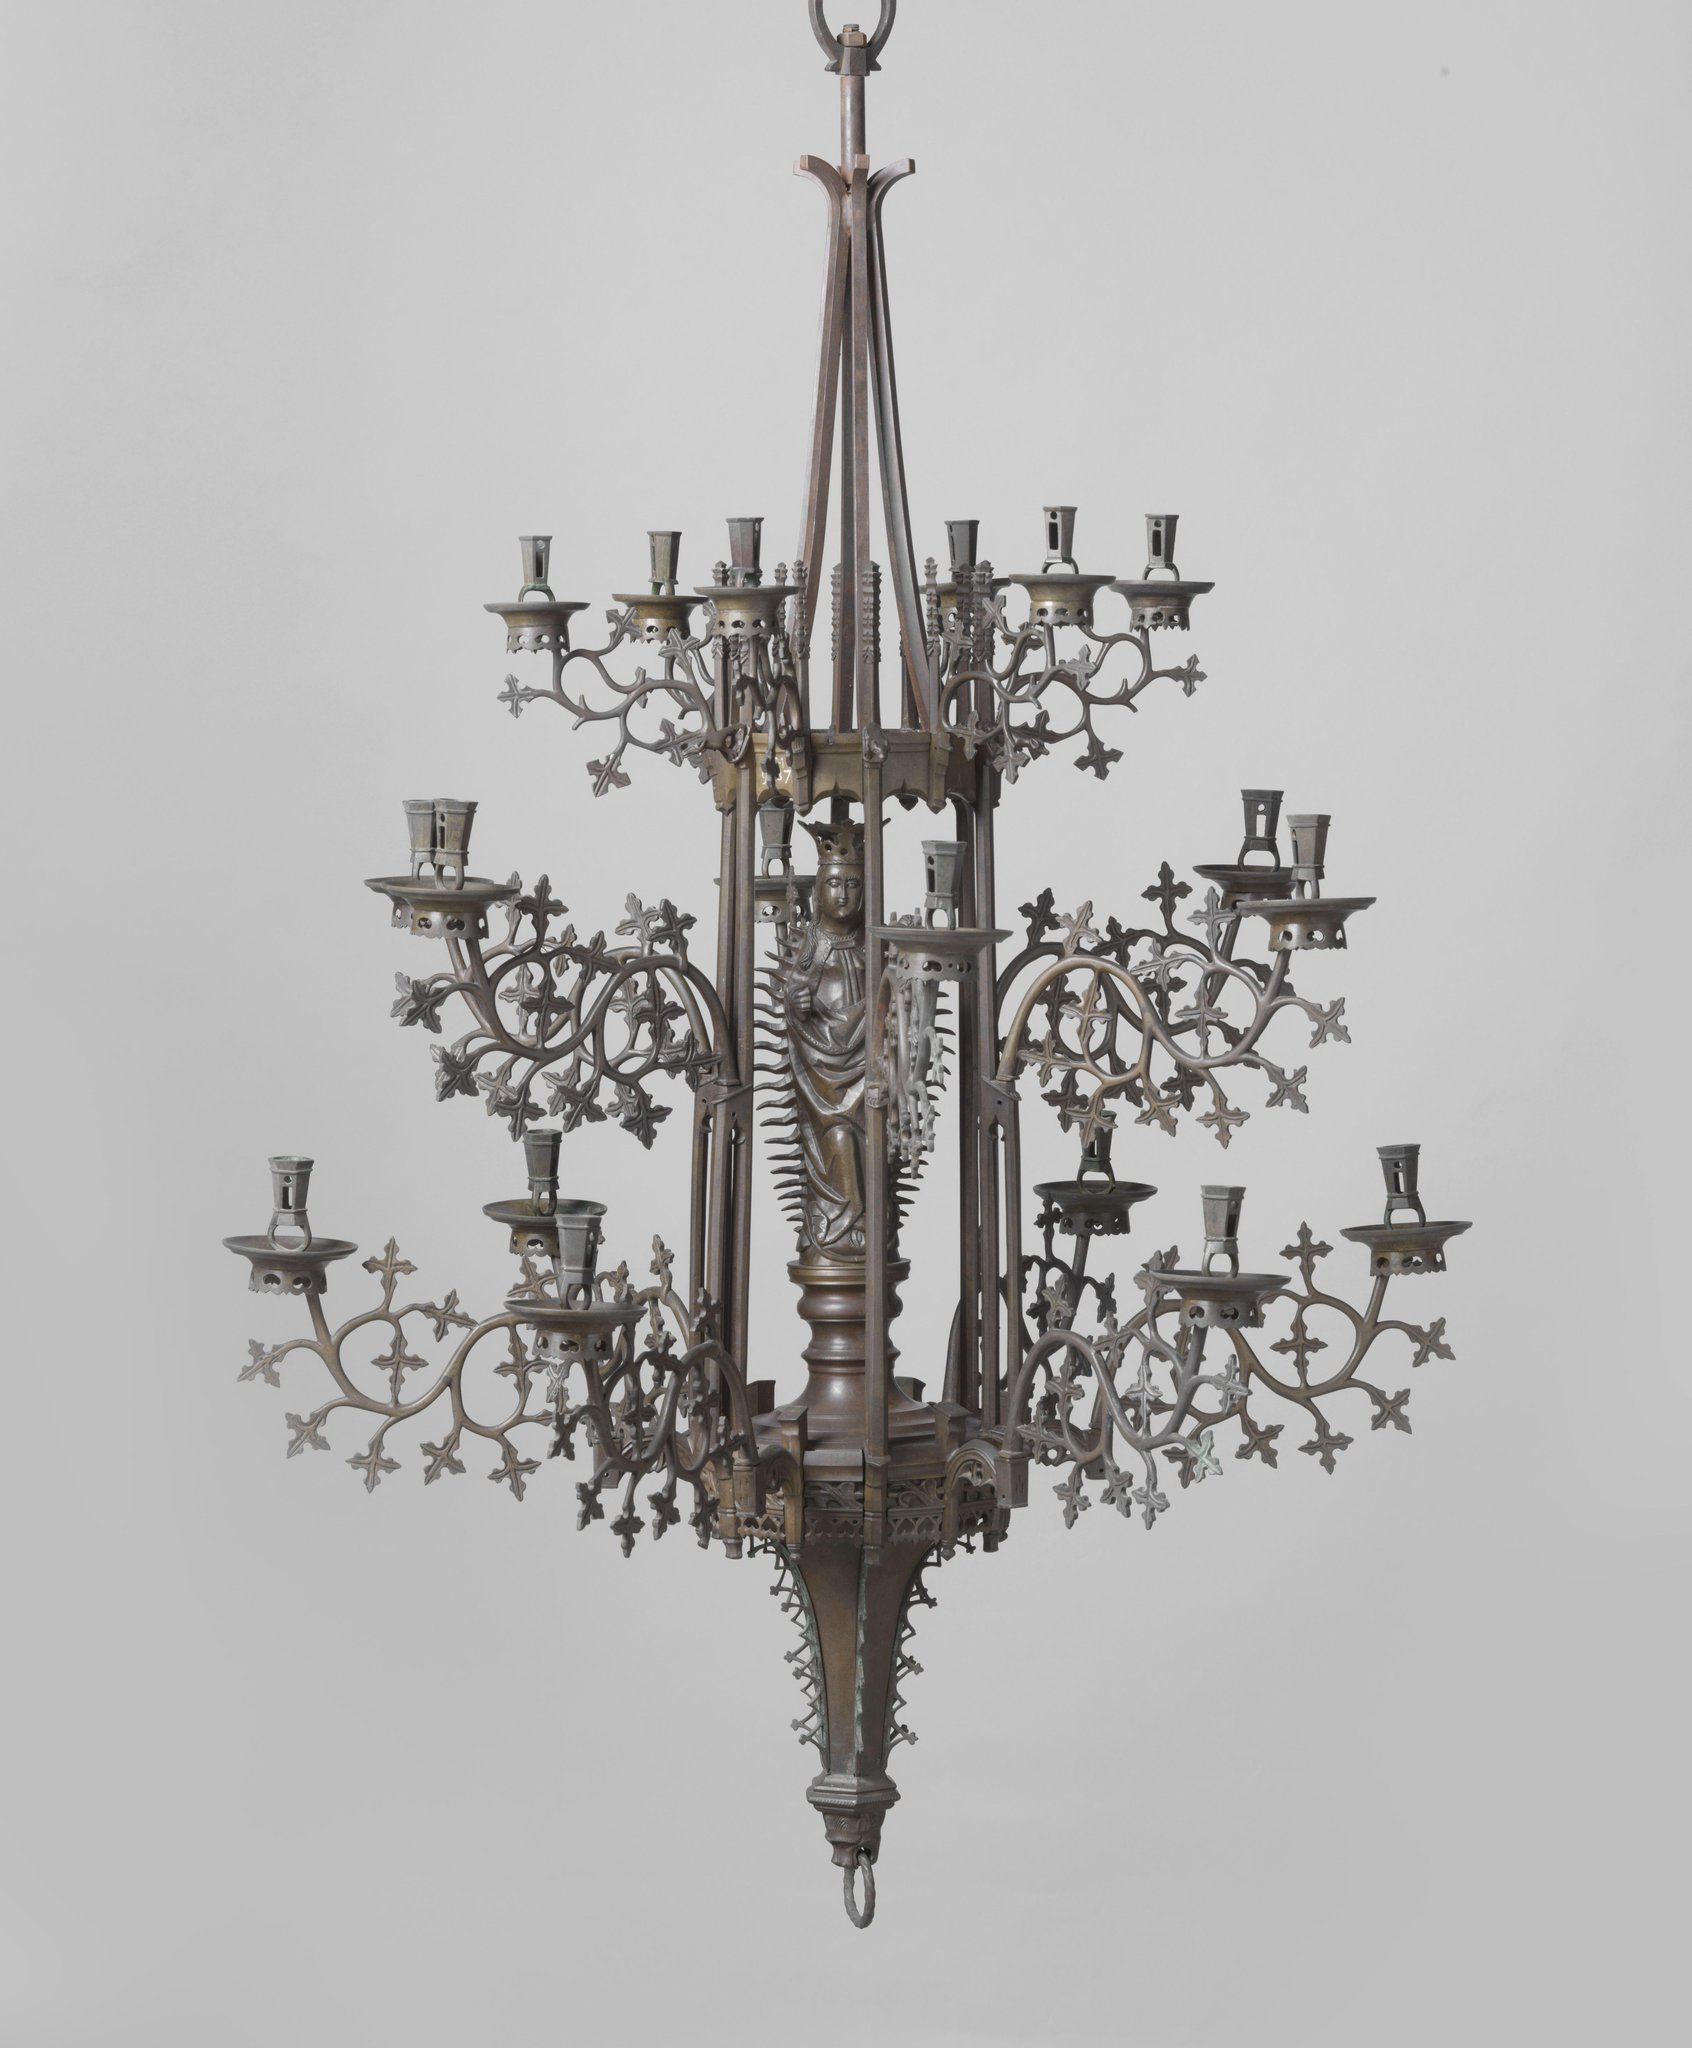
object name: chandelier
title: Kaarsenarm van kaarsenkroon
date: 1475-1485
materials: brass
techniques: casting, metalworking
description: Kaarsenarm behorende bij een kaarsenkroon van drie hoogten met Mariakapel in het midden. De arm is twee maal gebogen en heeft elf bladeren. Aan het uiteinde rust de vetvanger, die aan de onderzijde een verticale gekartelde rand met kruisbloemmotieven heeft. De kaarsenhouder is zesvlakkig met een geperforeerde zijde aan voor- en achterkant en heeft een verticaal ringvormig onderstuk. Dit is de vijfde arm van de middelste ring (midden van de spijlen), genummerd met 5 stippen.